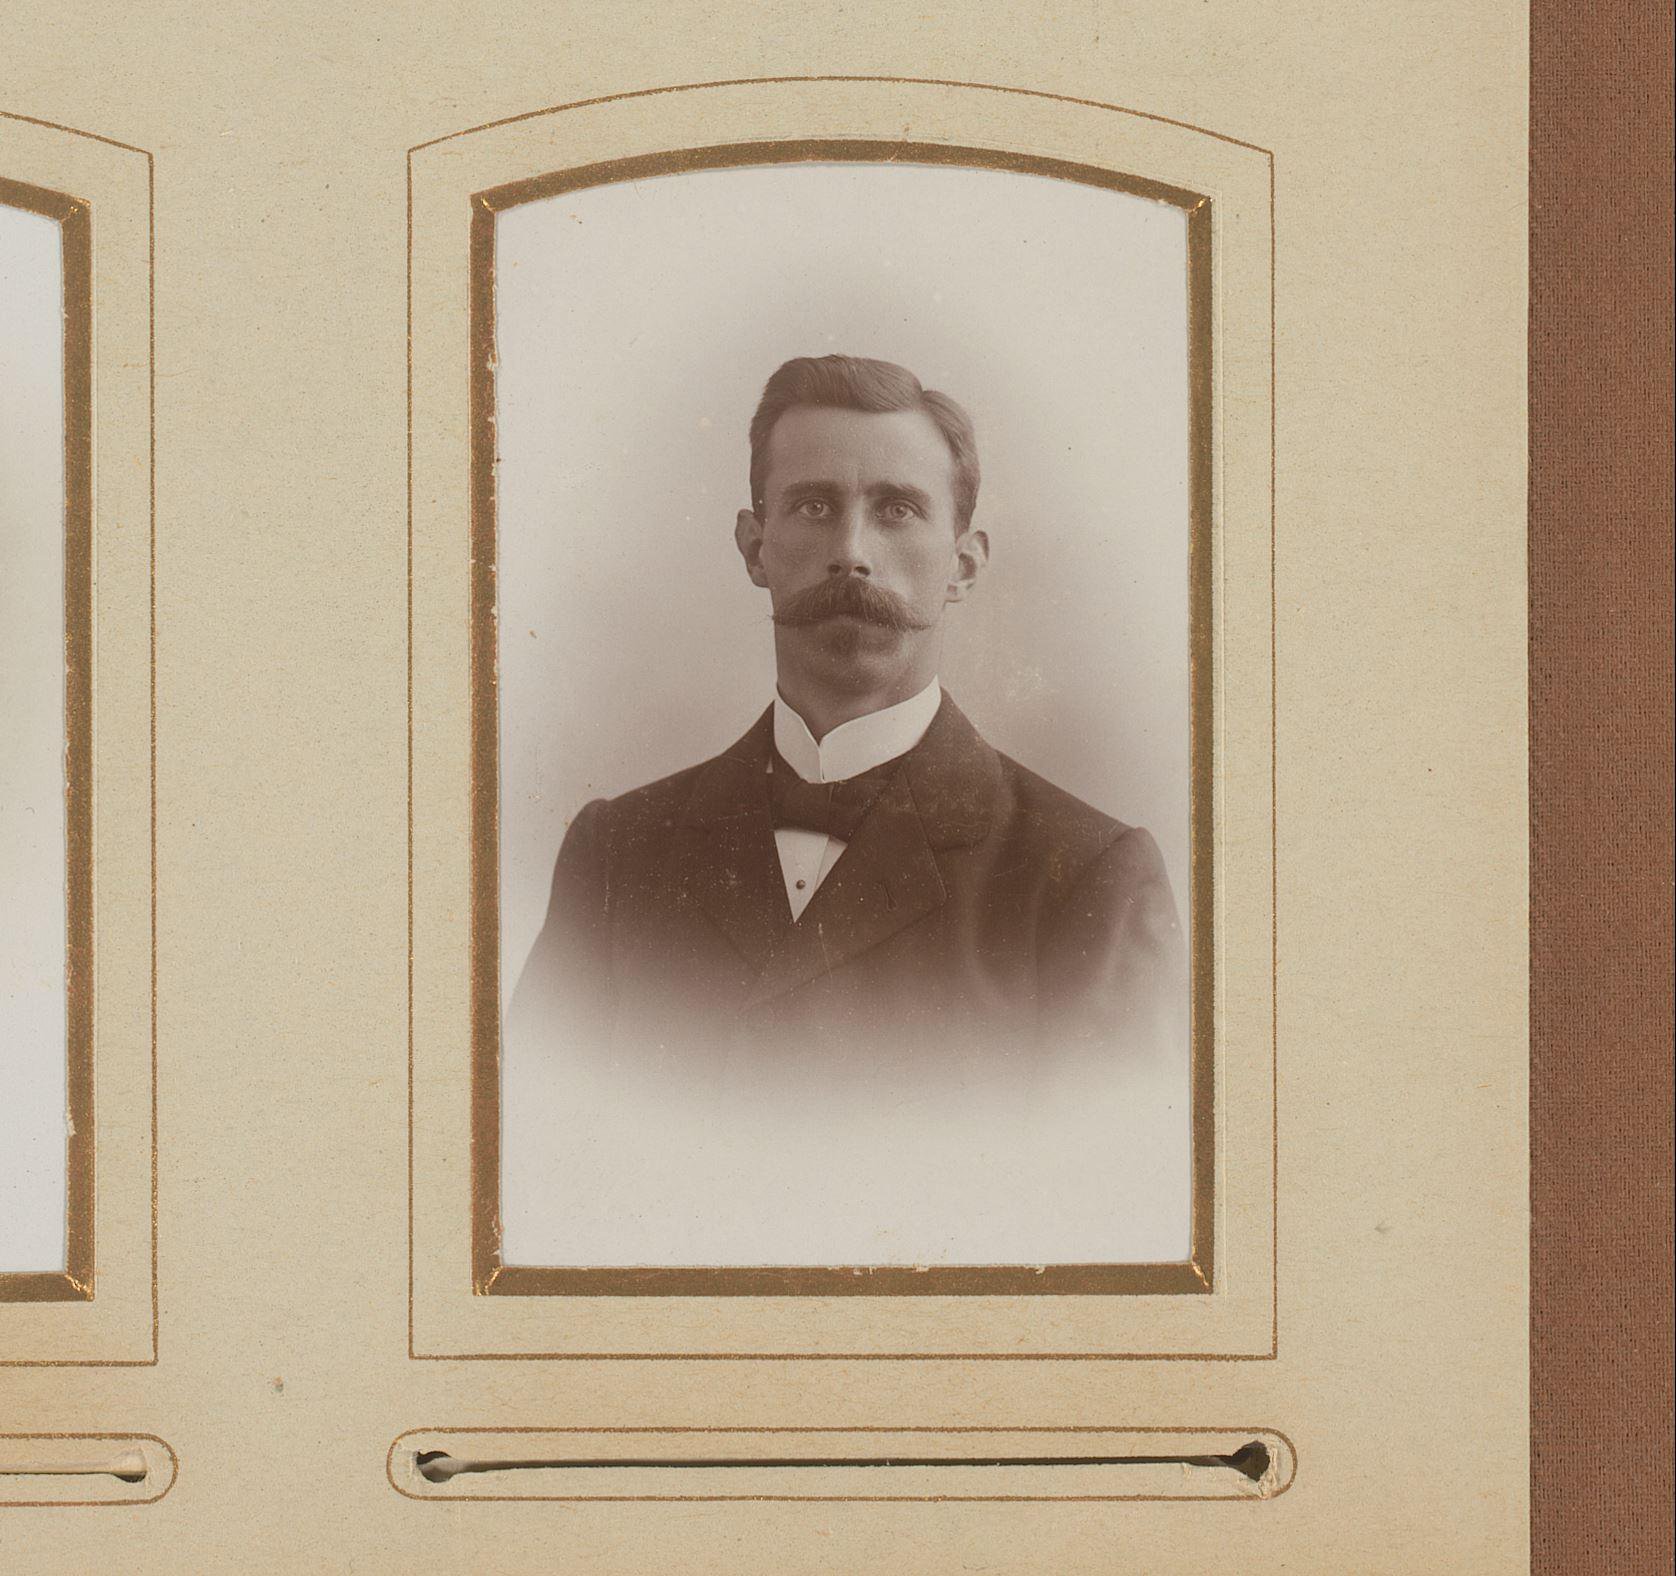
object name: album leaf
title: Portret van een man met snor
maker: machiel hendricus laddé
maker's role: fotograaf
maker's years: 1866-1932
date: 1892-1906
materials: cardboard, photographic support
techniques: collodion silver print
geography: amsterdam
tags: moustache, historical persons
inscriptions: inscription: ‘Fotografie/ Artistique/ M. H. Laddé/ Amsterdam/ Nieuwendijk 57-59/ boven de firma MERKELBACH & Co./ Het Cliché wordt voor verdere bestellingen bewaard.’